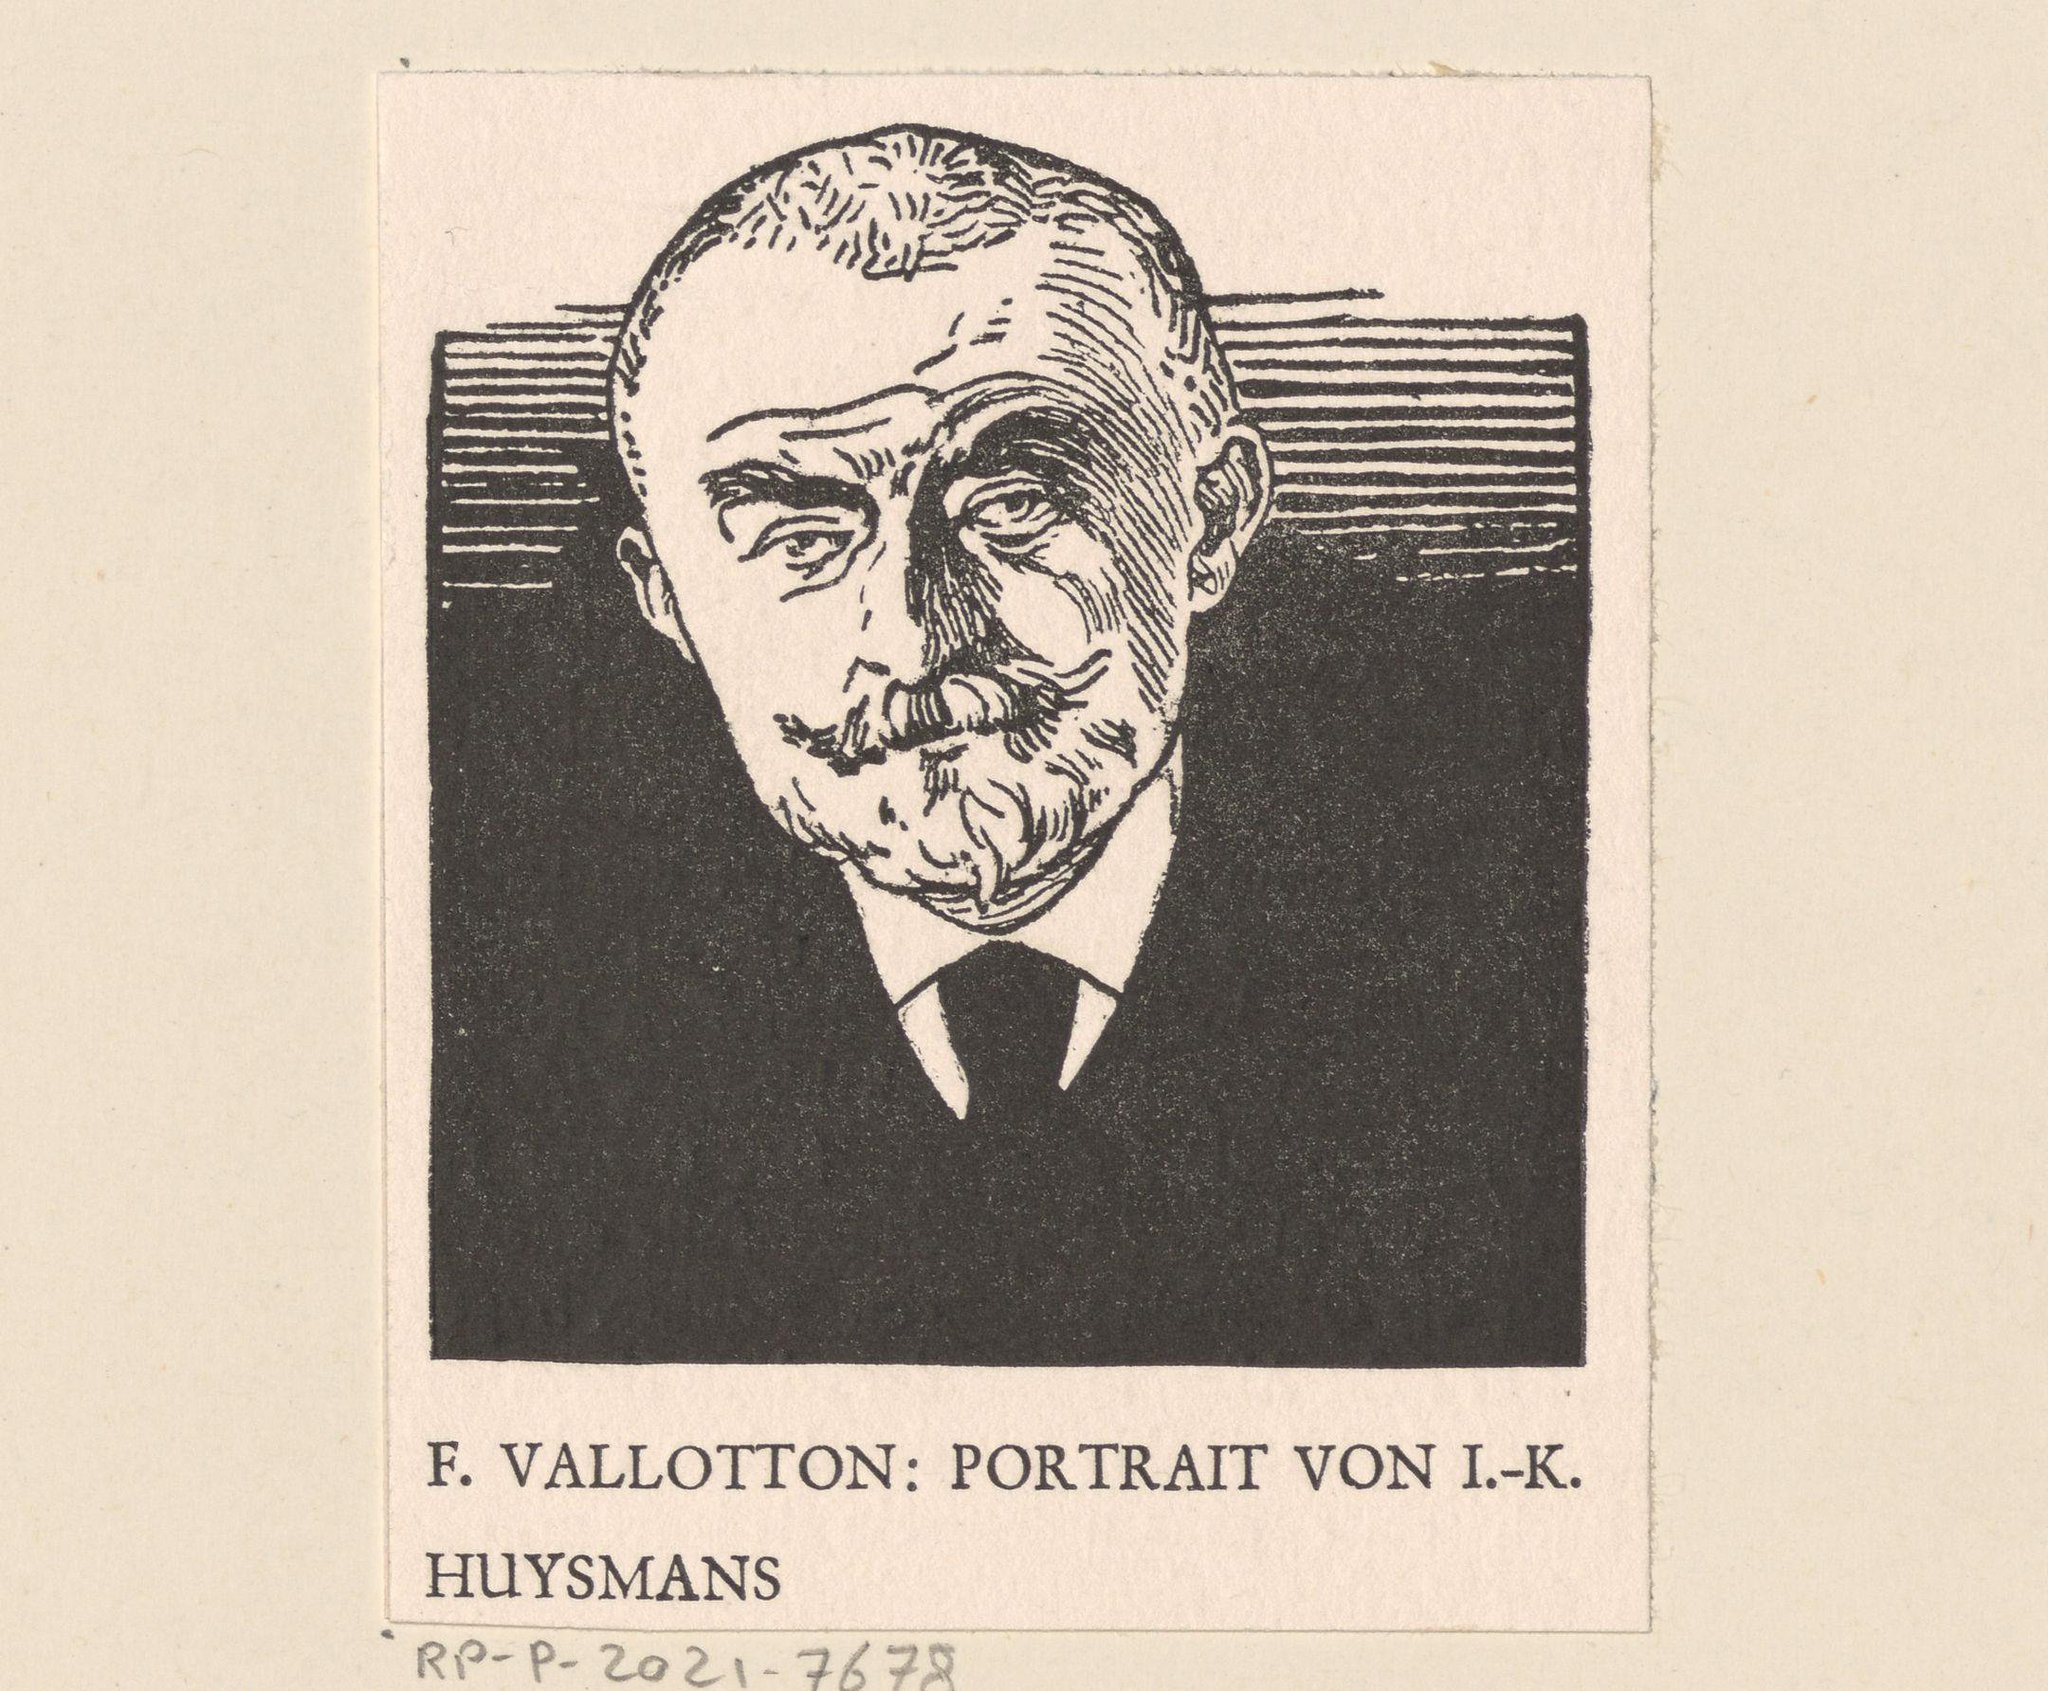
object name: photomechanical print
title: Portret van Joris-Karl Huysmans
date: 1895-1930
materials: paper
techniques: letterpress printing, printing block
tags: paris, joris-karl huysmans, historical persons, portrait of a writer